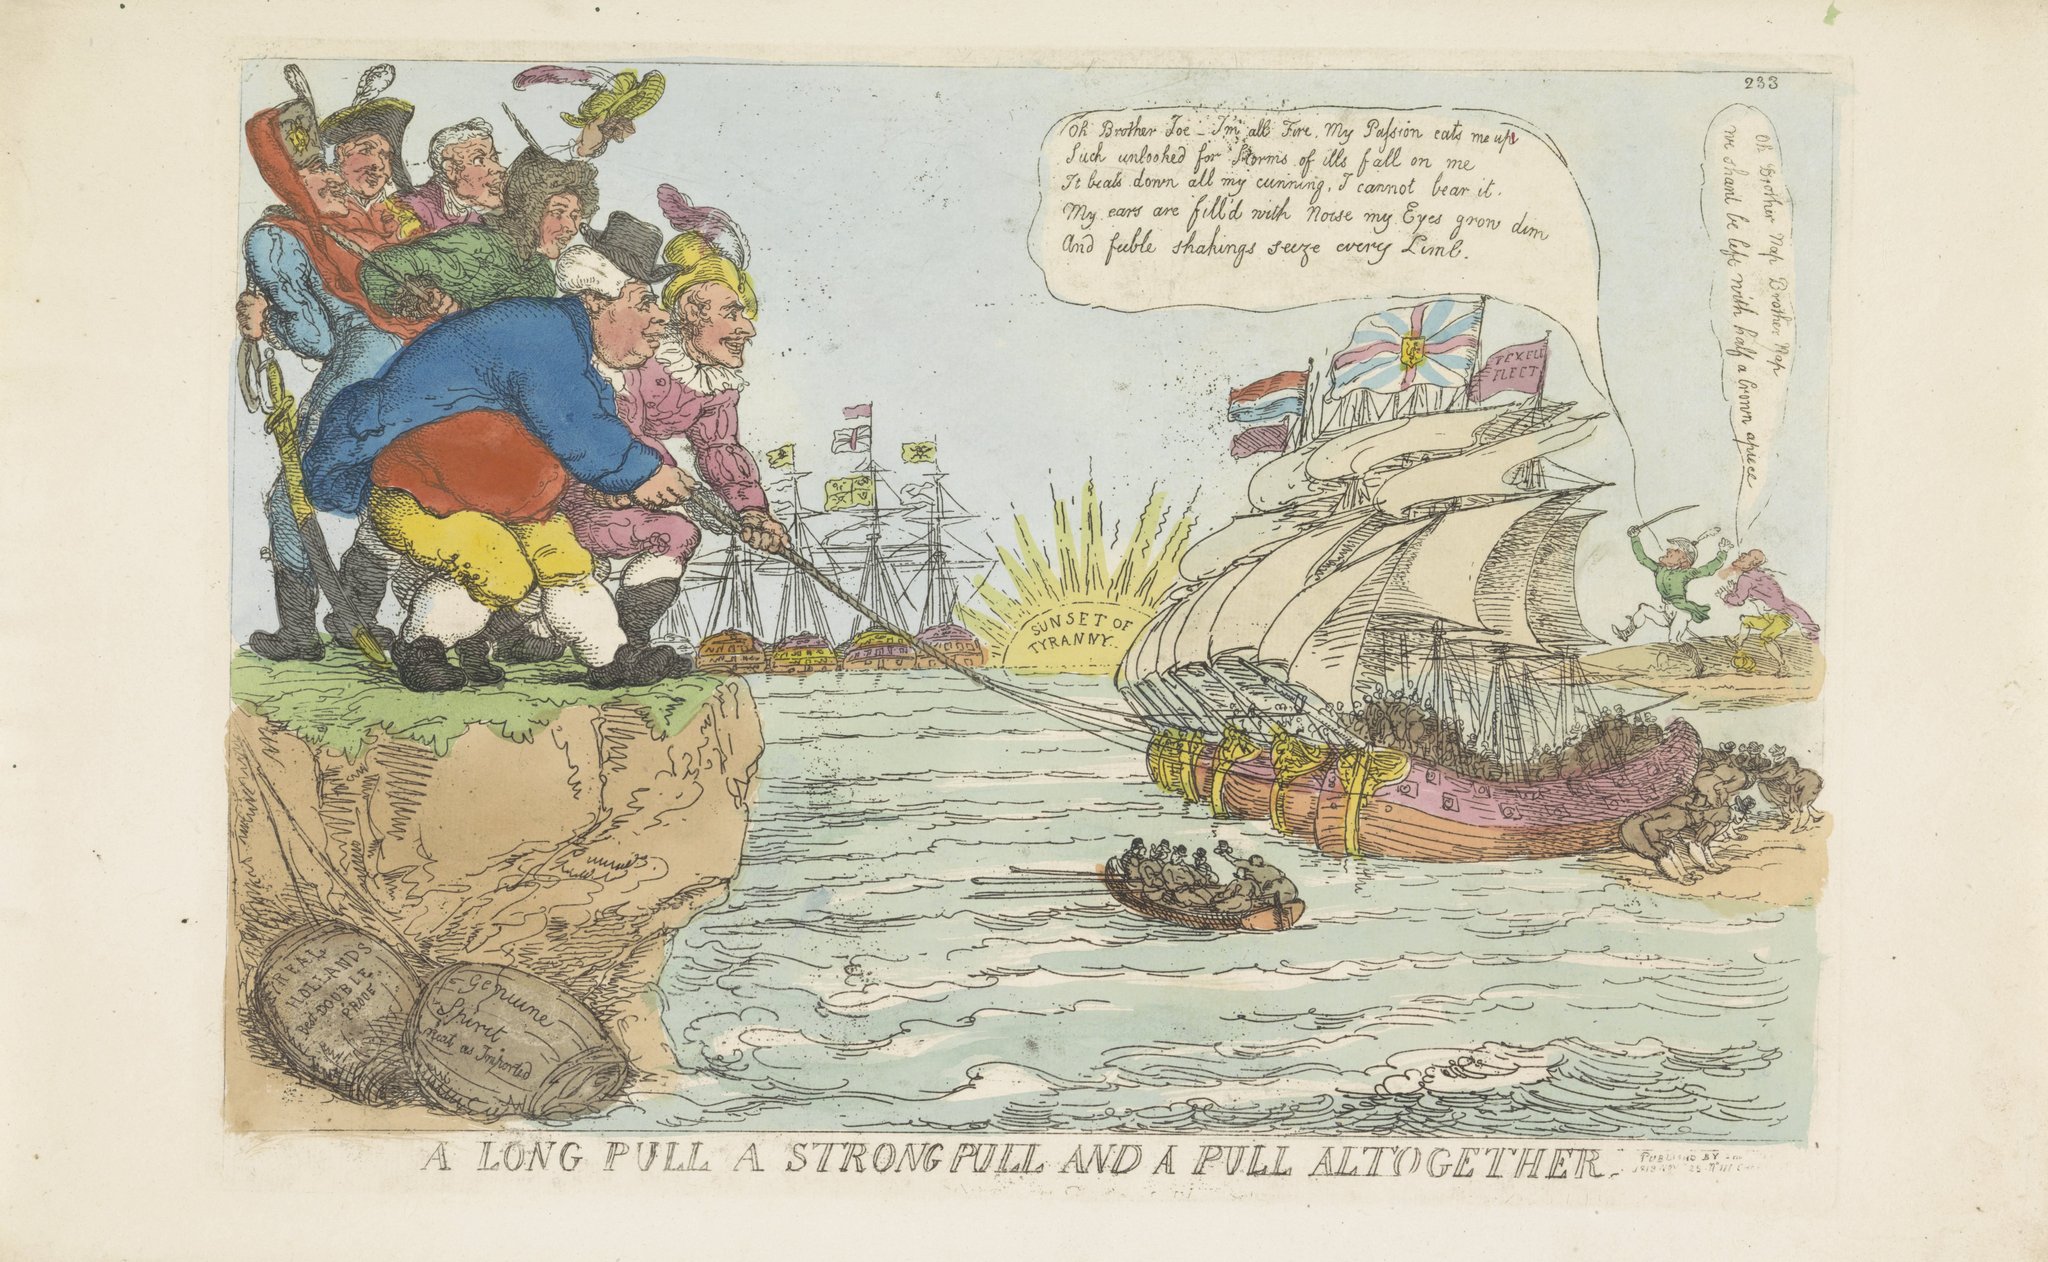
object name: cartoon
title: A long pull a strong pull and a pull altogether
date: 1813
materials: paper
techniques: etching, hand coloring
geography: england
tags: napoleon i (emperor of the french), drawing, pulling something, navy (+ sailing-ships)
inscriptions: collector's mark: Lugt 2760, collector's mark: Lugt 2228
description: Spotprent op Napoleon na zijn verlies van Holland, 1813. De bondgenoten (Engeland, Spanje, Rusland, Pruisen e.a.) trekken vanaf een klif gezamenlijk met touwen de Hollandse vloot (op een vlag staat 'Texel Fleet') vanaf Texel weer vlot. De schepen zijn bemand door Hollanders die ook op het land meehelpen om de schepen in het water te duwen. Op het water ook een Hollandse sloep. Linksonder bij de klif liggen twee vaten Hollandse jenever. Rechts maken Napoleon en zijn broer Jozef zich druk om hun verliezen van Holland en Spanje. In het verschiet gaat de 'zon van tirannie' onder, hiernaast wacht de vloot van de bondgenoten op de Hollandse schepen. Genummerd rechtsboven: 233.